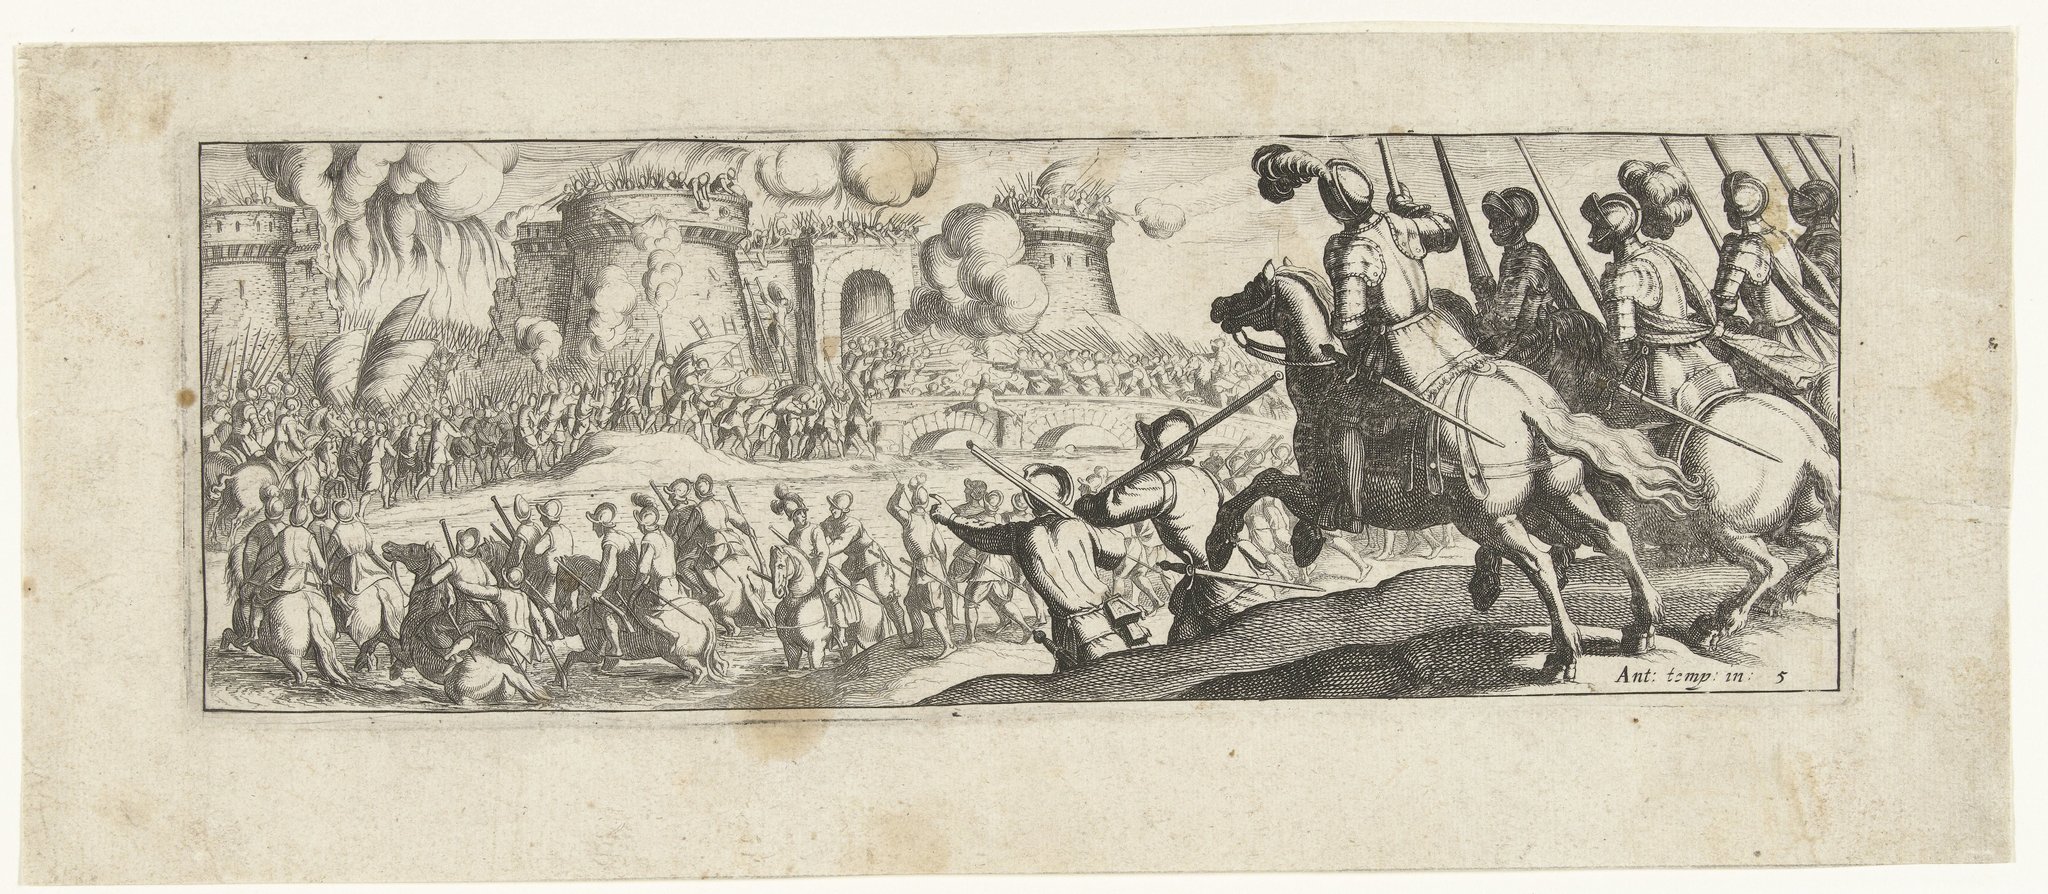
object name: print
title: Inname van een burcht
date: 1591-1659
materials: paper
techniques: engraving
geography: amsterdam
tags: fortress, being attacked; defence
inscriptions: collector's mark: Lugt 2227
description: Gevechtsscène met de inname van een burcht. Prent vijf uit een serie met gevechtsscènes naar Antonio Tempesta.